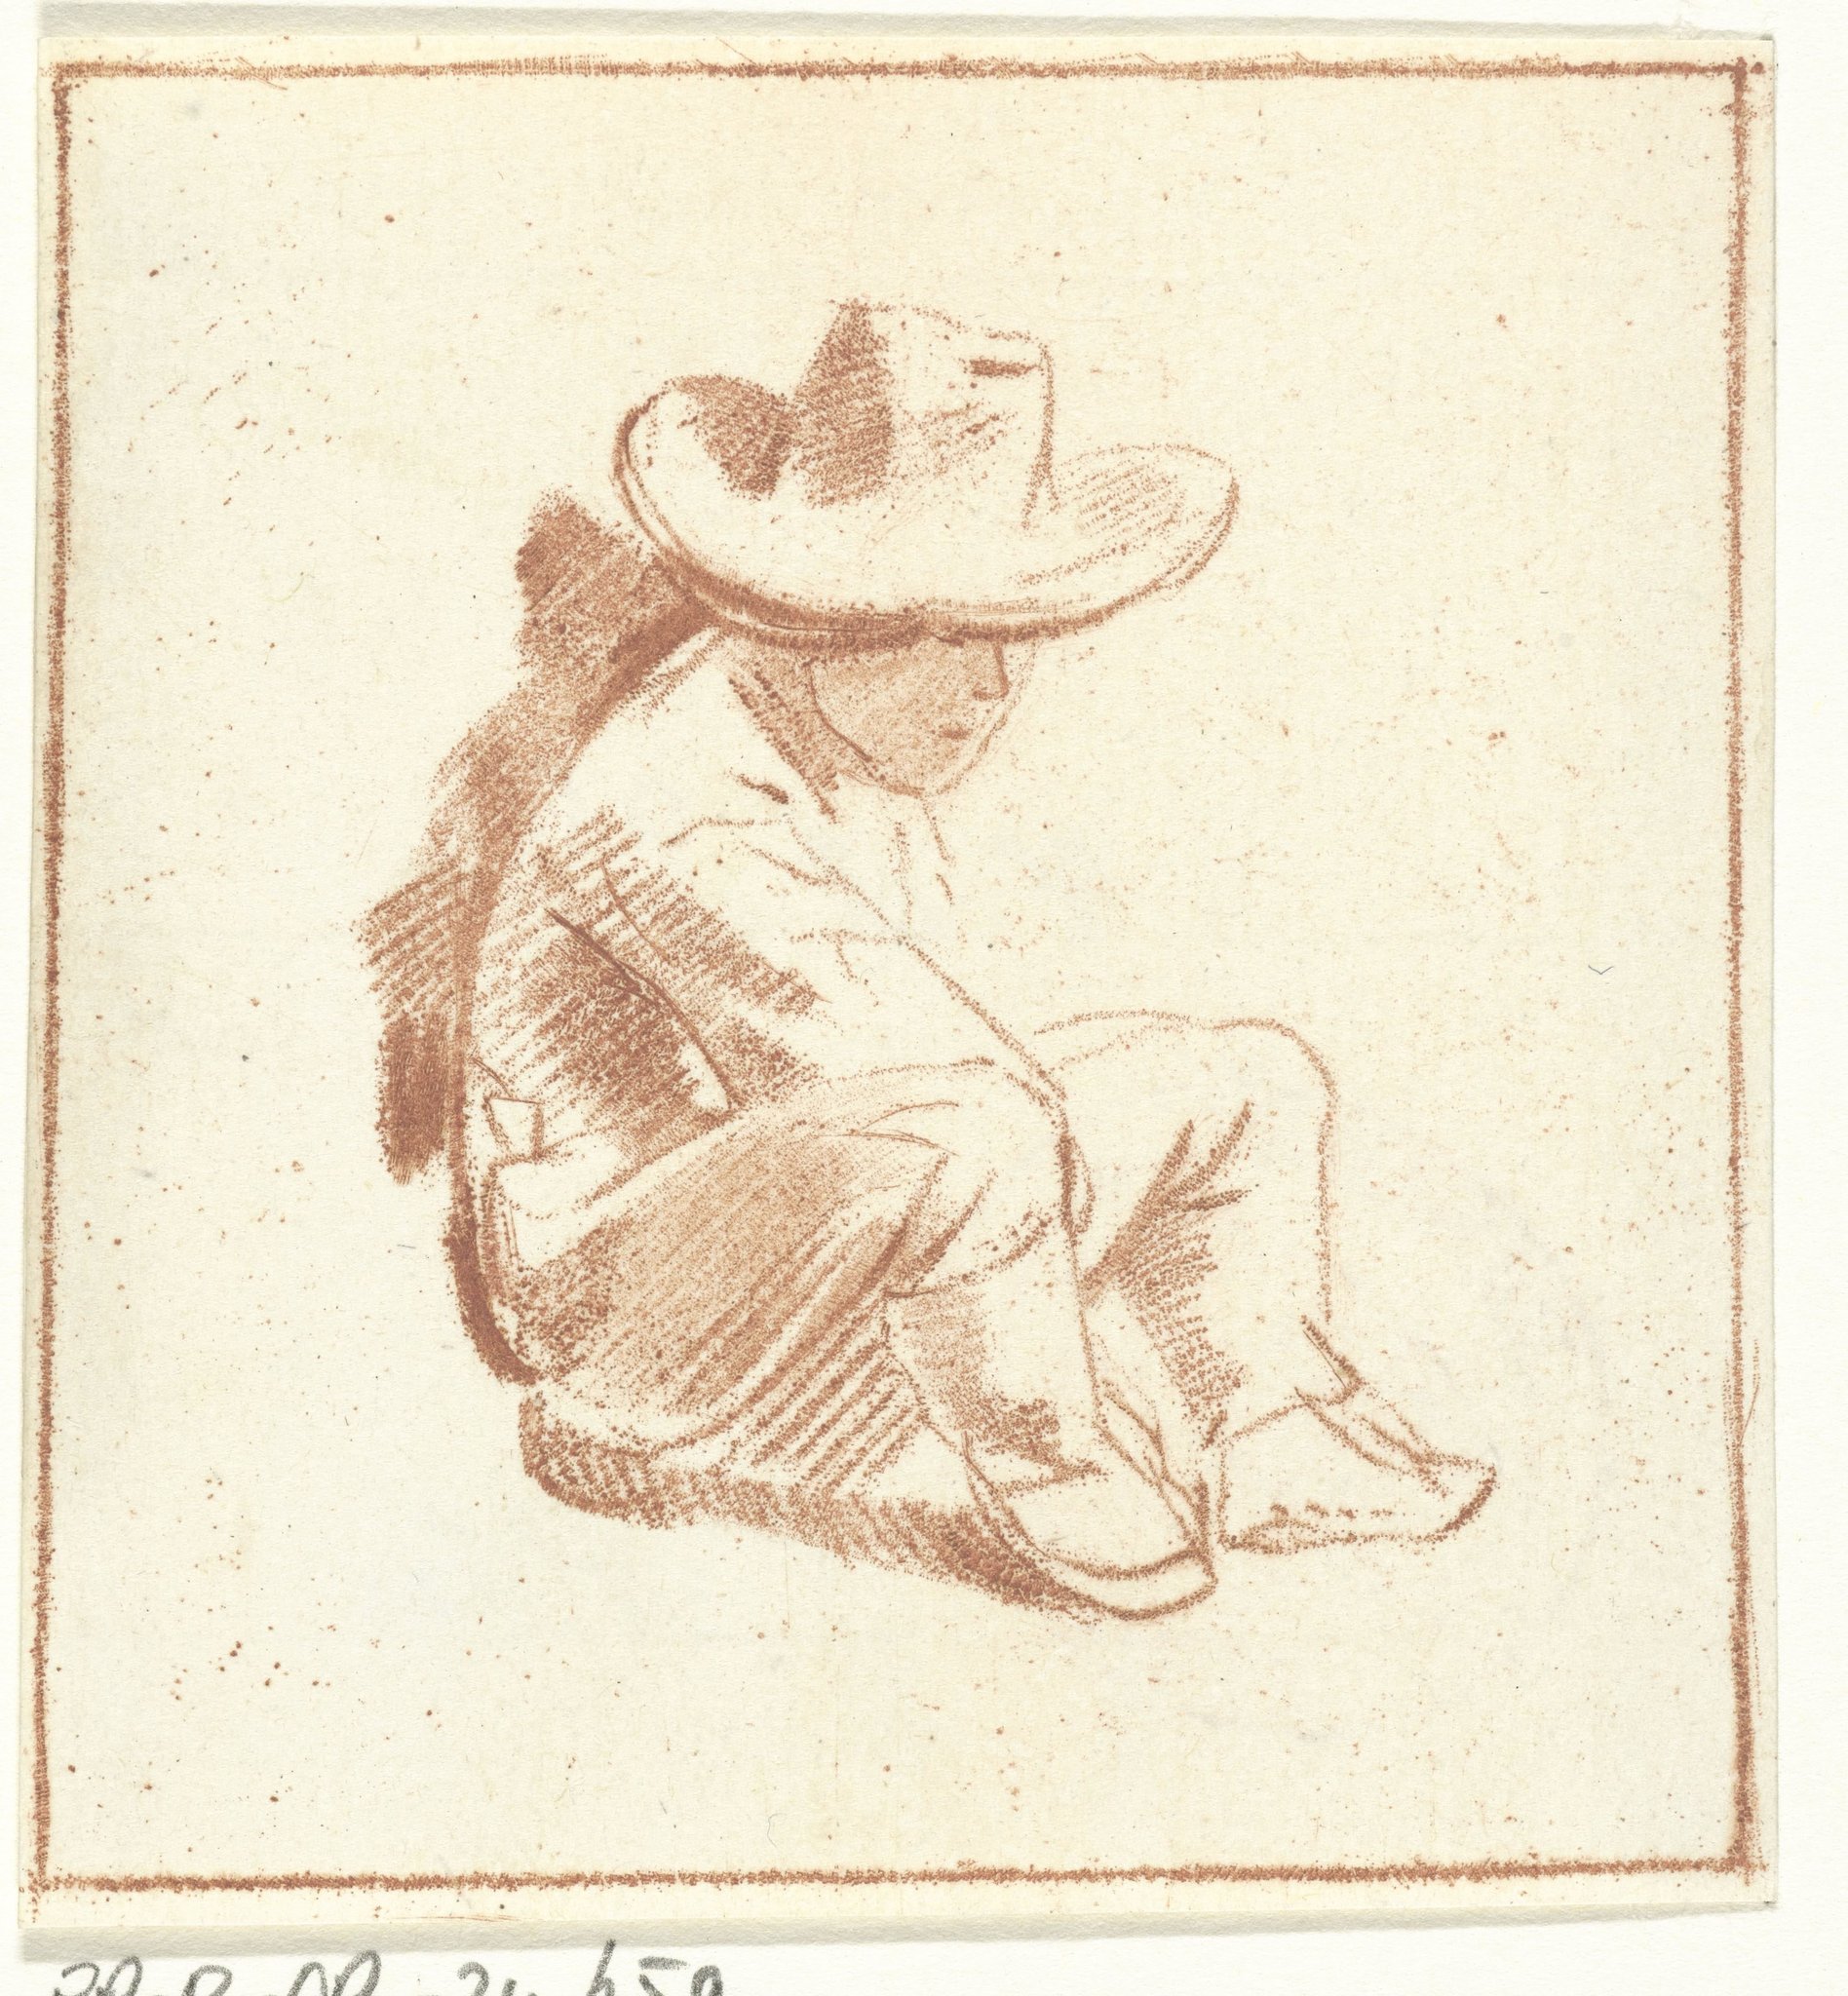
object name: print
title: Zittende jongen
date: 1767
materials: paper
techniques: printing, printmaking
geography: amsterdam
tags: sitting figure, head-gear: hat (+ men's clothes)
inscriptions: collector's mark: Lugt 240